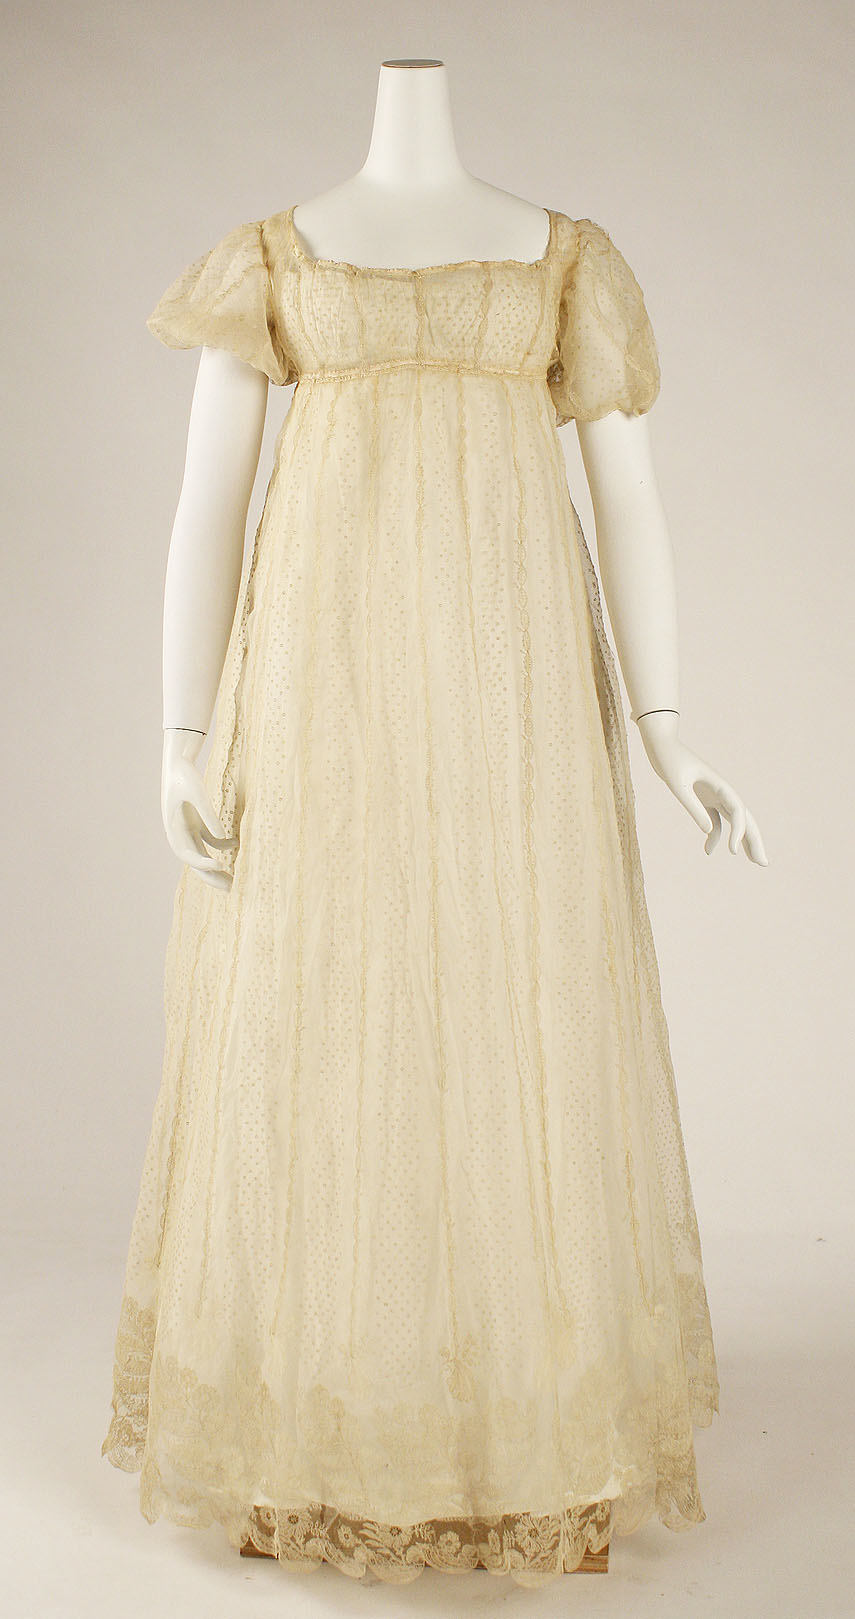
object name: dress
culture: french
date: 1804-1814